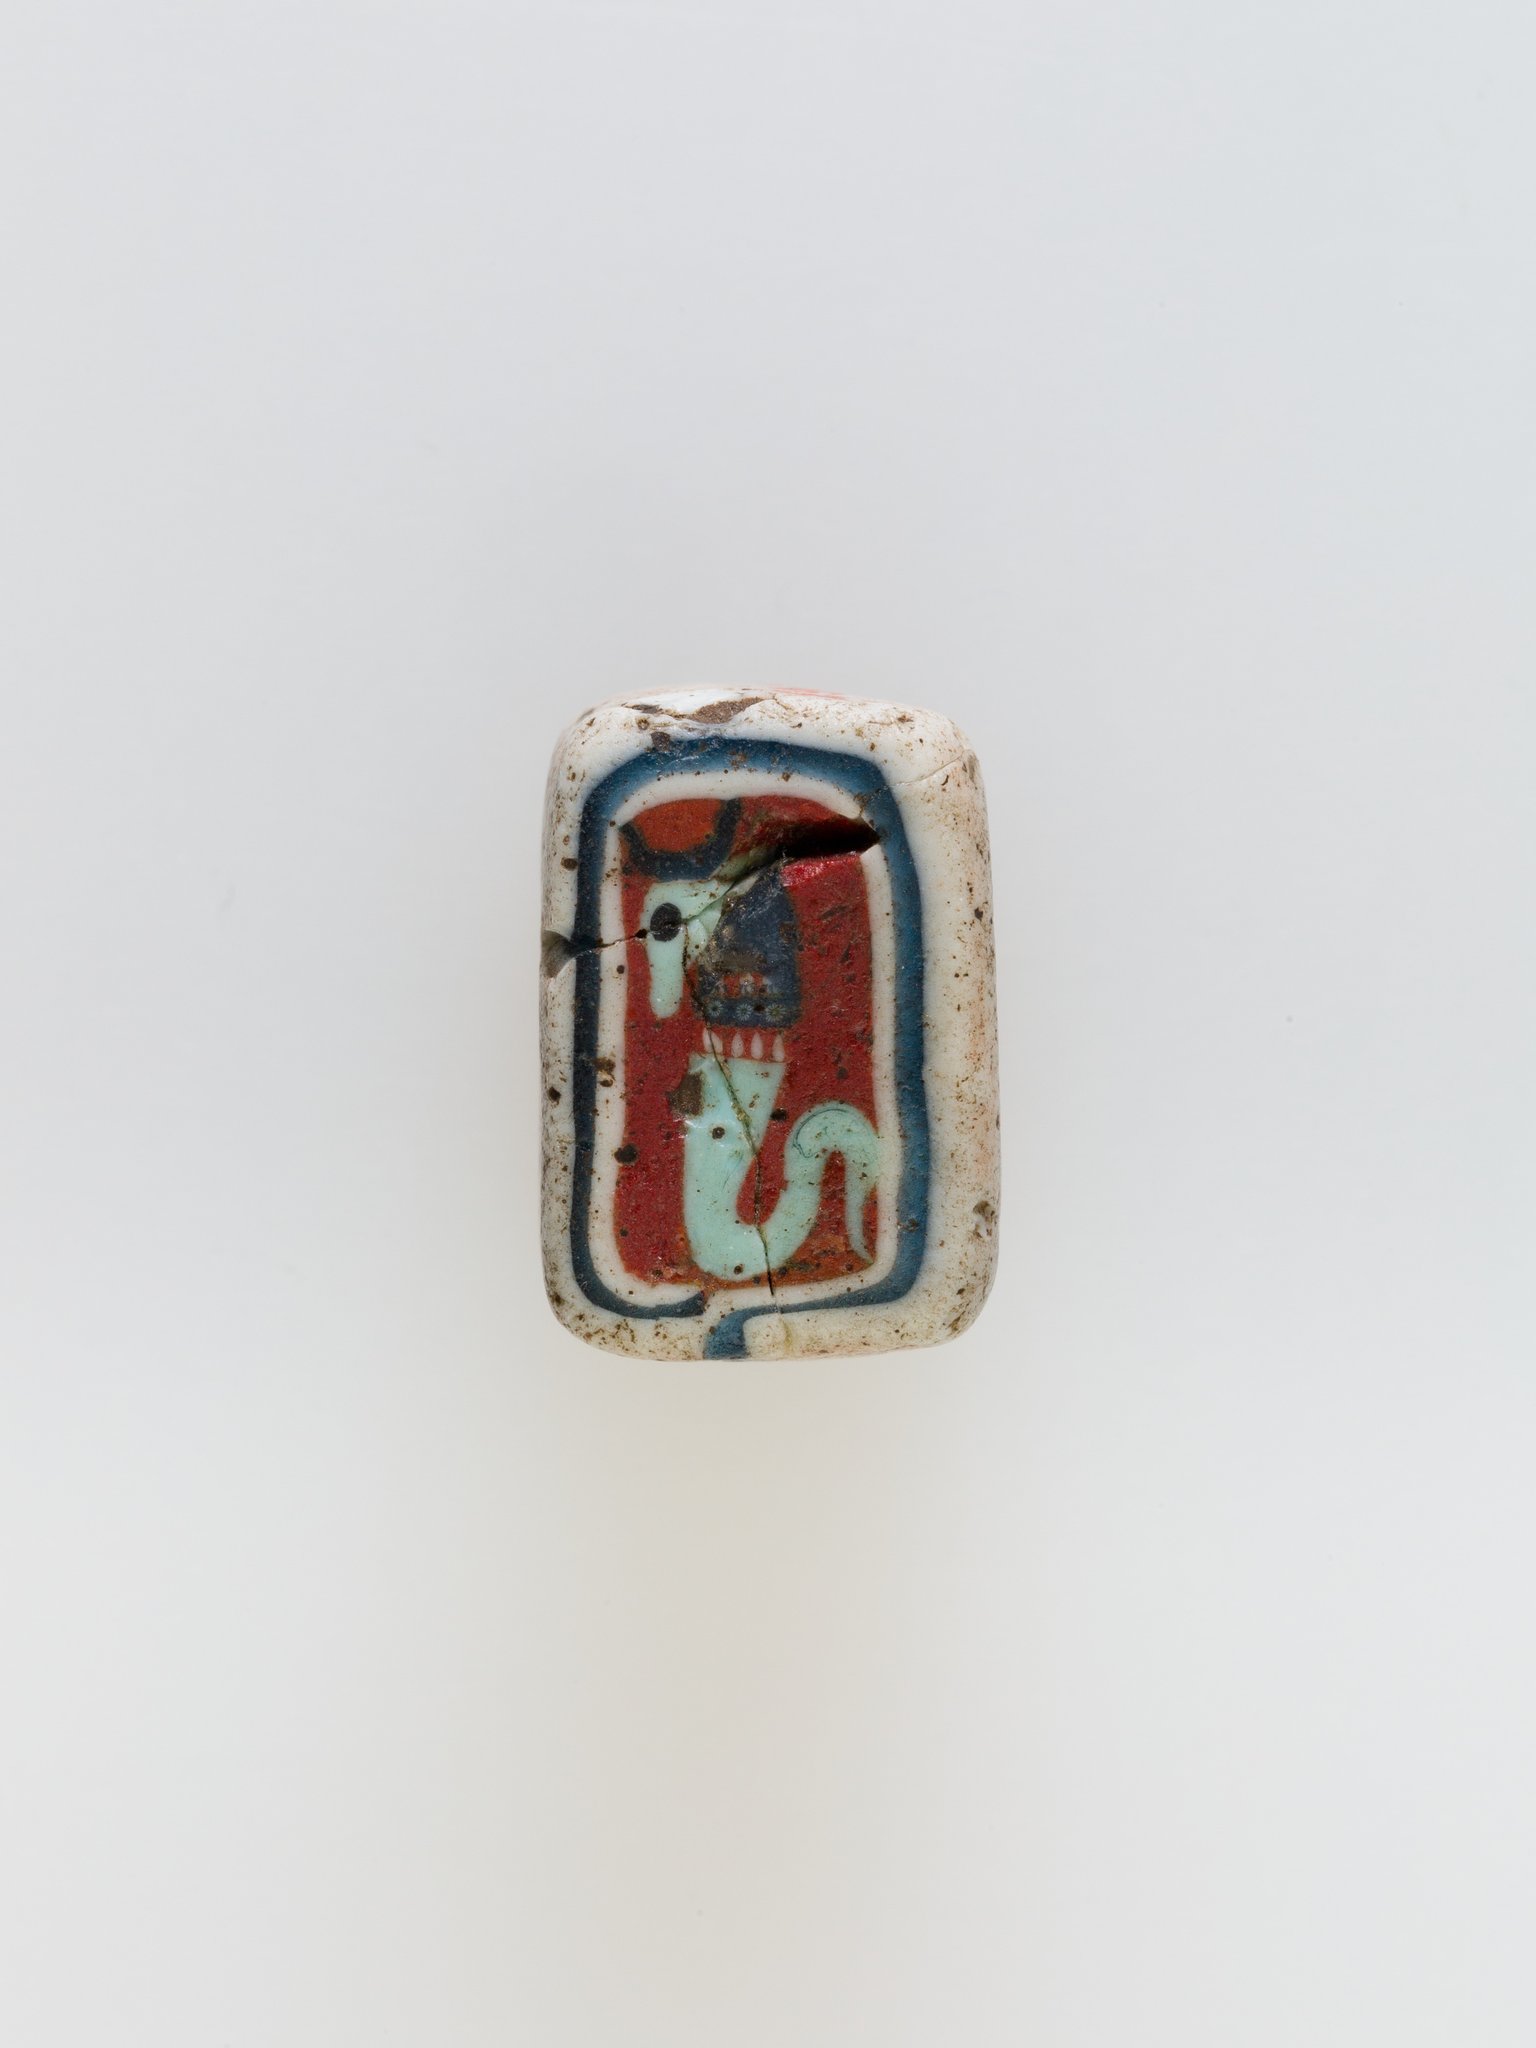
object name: cane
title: Cane, cow-headed serpent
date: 100 BCE-100 CE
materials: glass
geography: egypt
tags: serpents